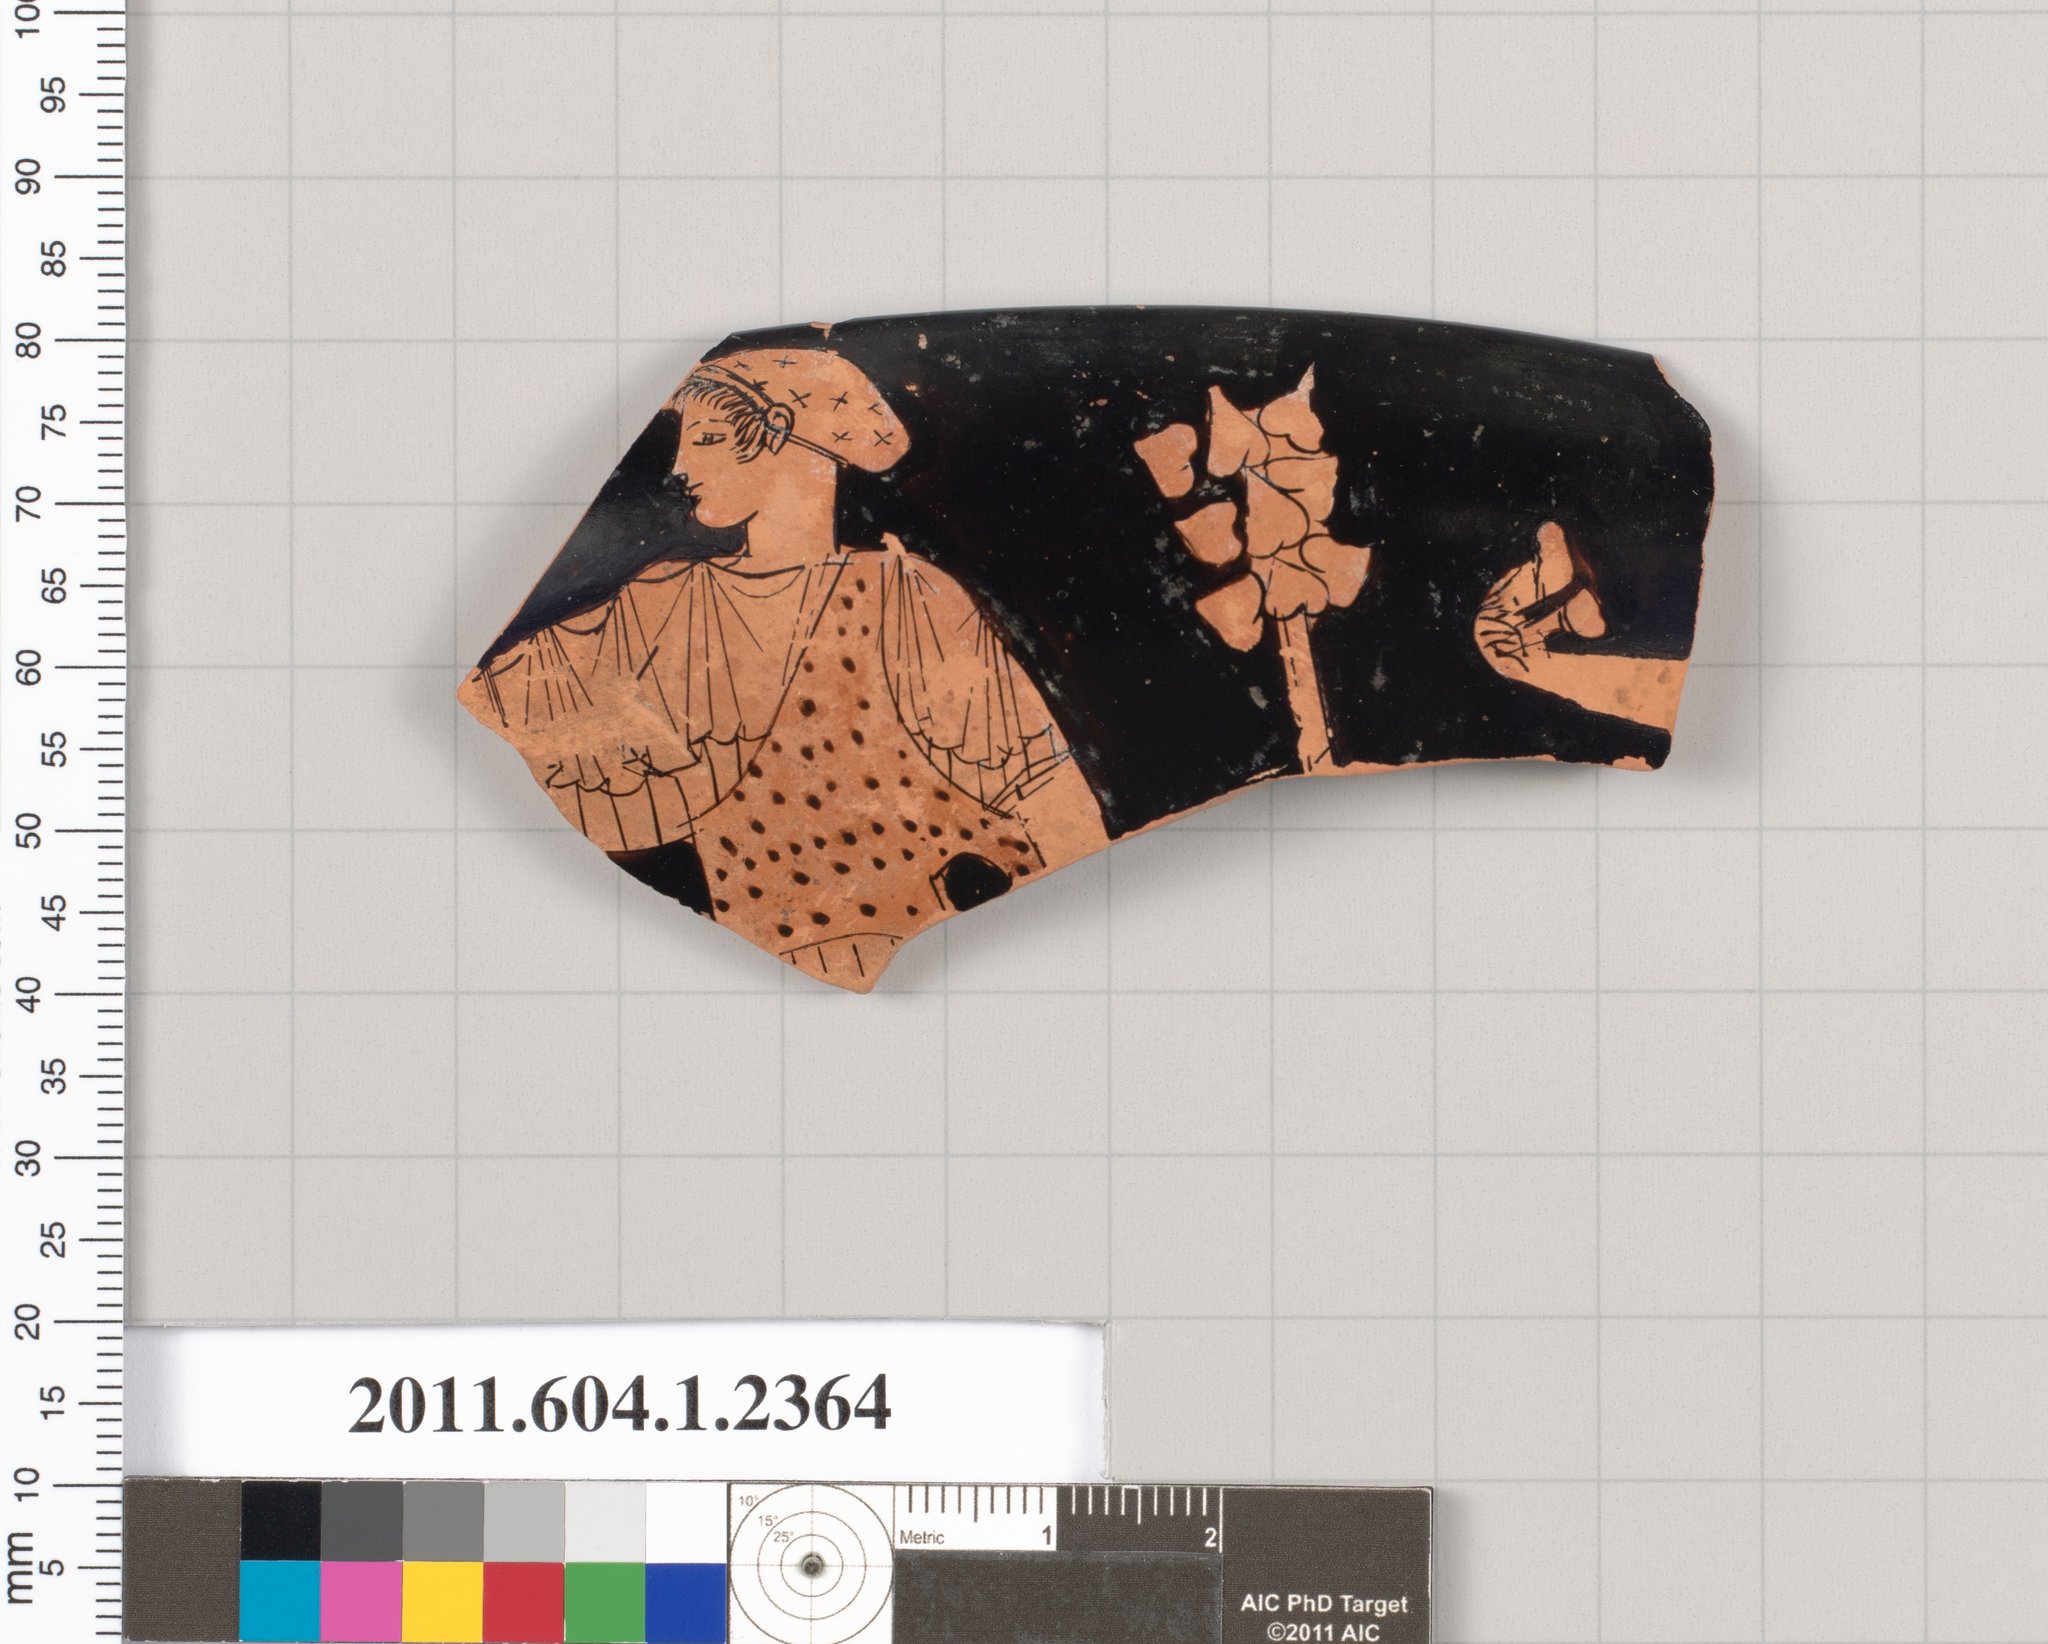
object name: kylix fragment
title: Terracotta rim fragment of a kylix (drinking cup)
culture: greek, attic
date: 500-476 BCE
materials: terracotta